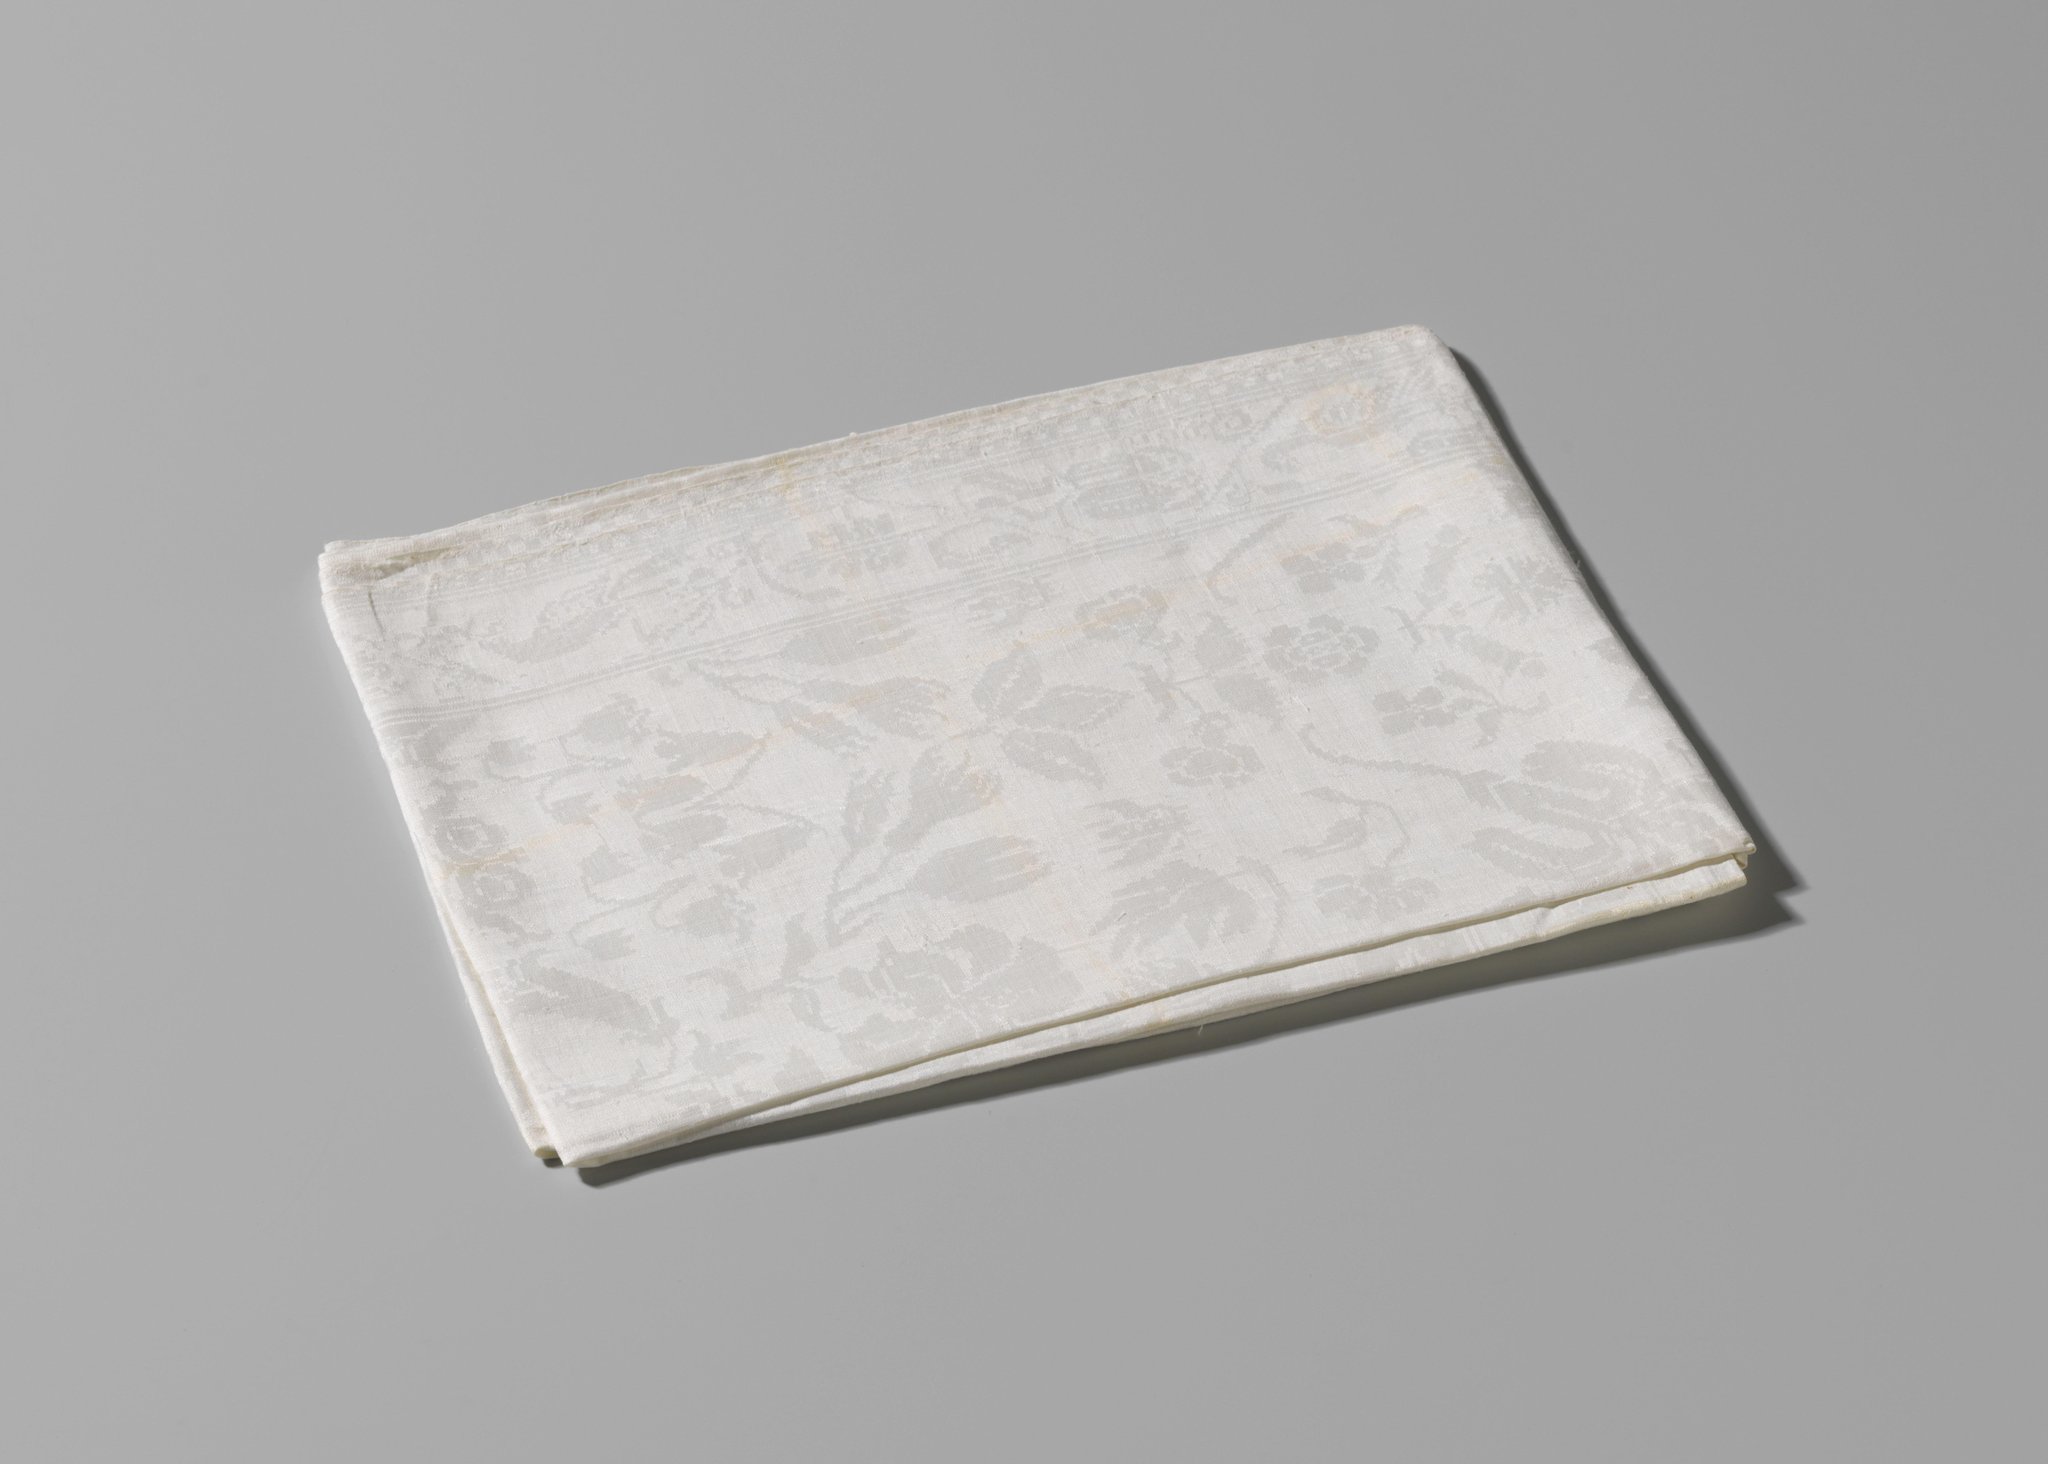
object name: napkin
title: Servet van wit linnendamast met de gekoppelde wapens Von Inn- und Kniphausen en Von Ewsum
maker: Anonymous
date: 1665-1670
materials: linen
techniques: damask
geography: northern netherlands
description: Servet van wit linnendamast met bloempatroon romdom de gekoppelde wapens Von Inn- und Kniphausen en Van Ewsum. Gemerkt: kroon LE 17.